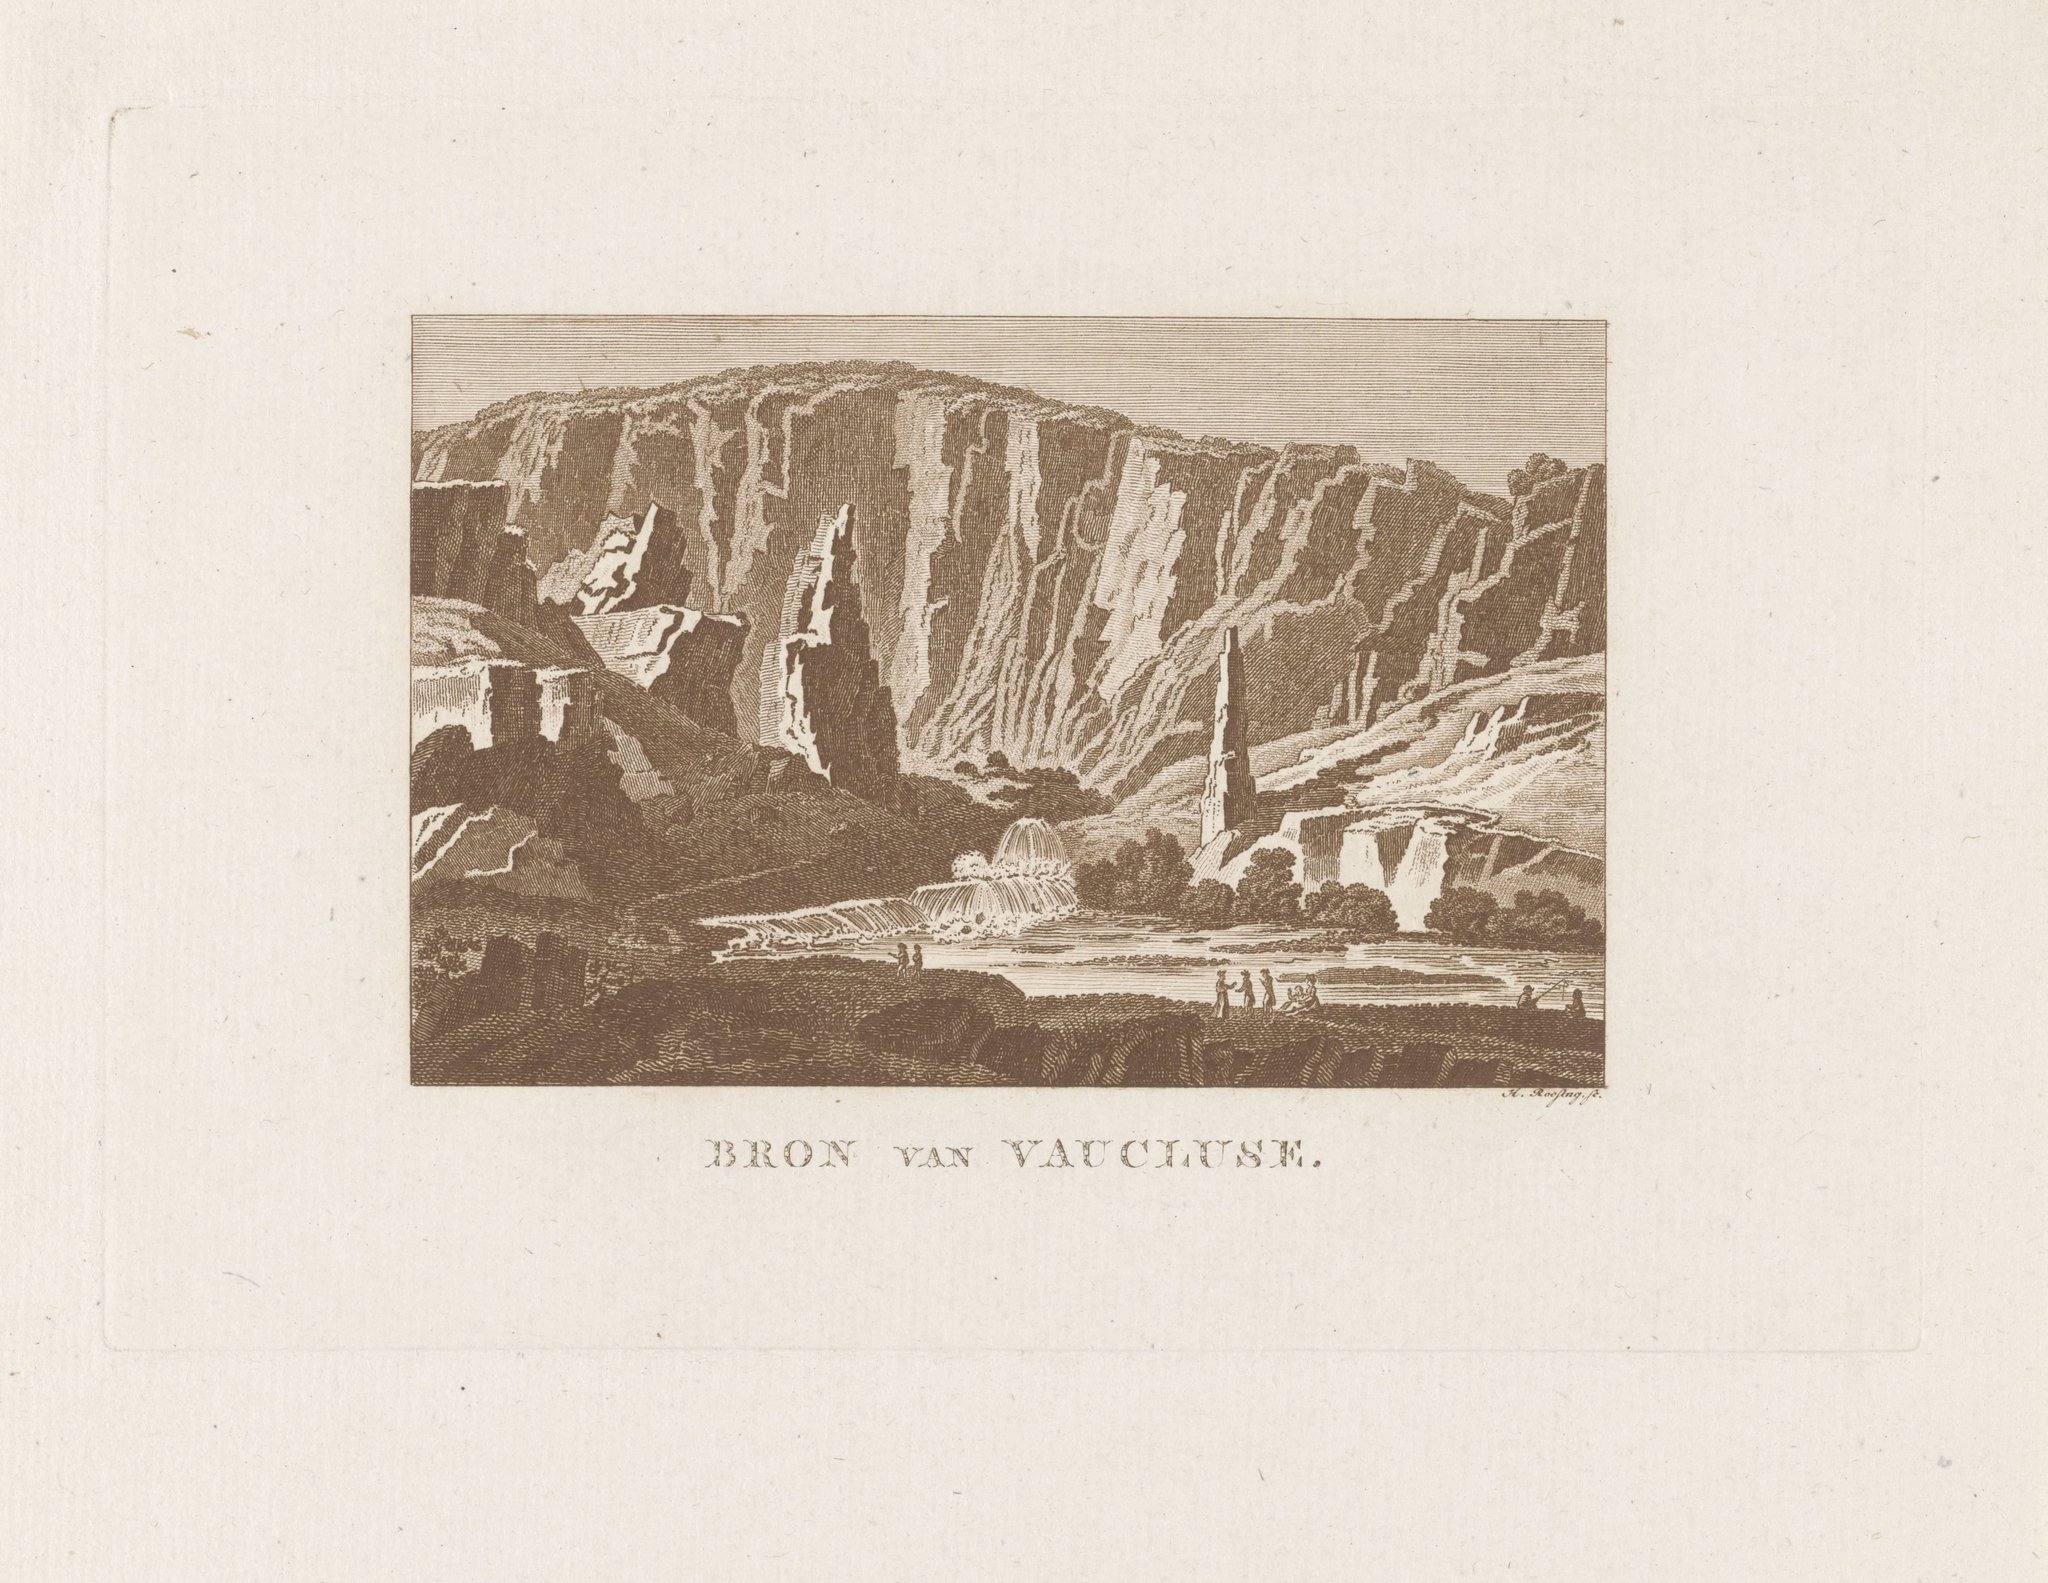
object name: print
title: Bron van Vaucluse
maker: hendrik roosing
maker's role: print maker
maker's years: 1763-1826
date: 1786-1826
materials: paper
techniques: etching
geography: rotterdam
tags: waterfall, fisherman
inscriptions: collector's mark: Lugt 2228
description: Gezicht op de bron van Vaucluse, in de omgeving van Avignon. Op de voorgrond enkele wandelaars en een visser.